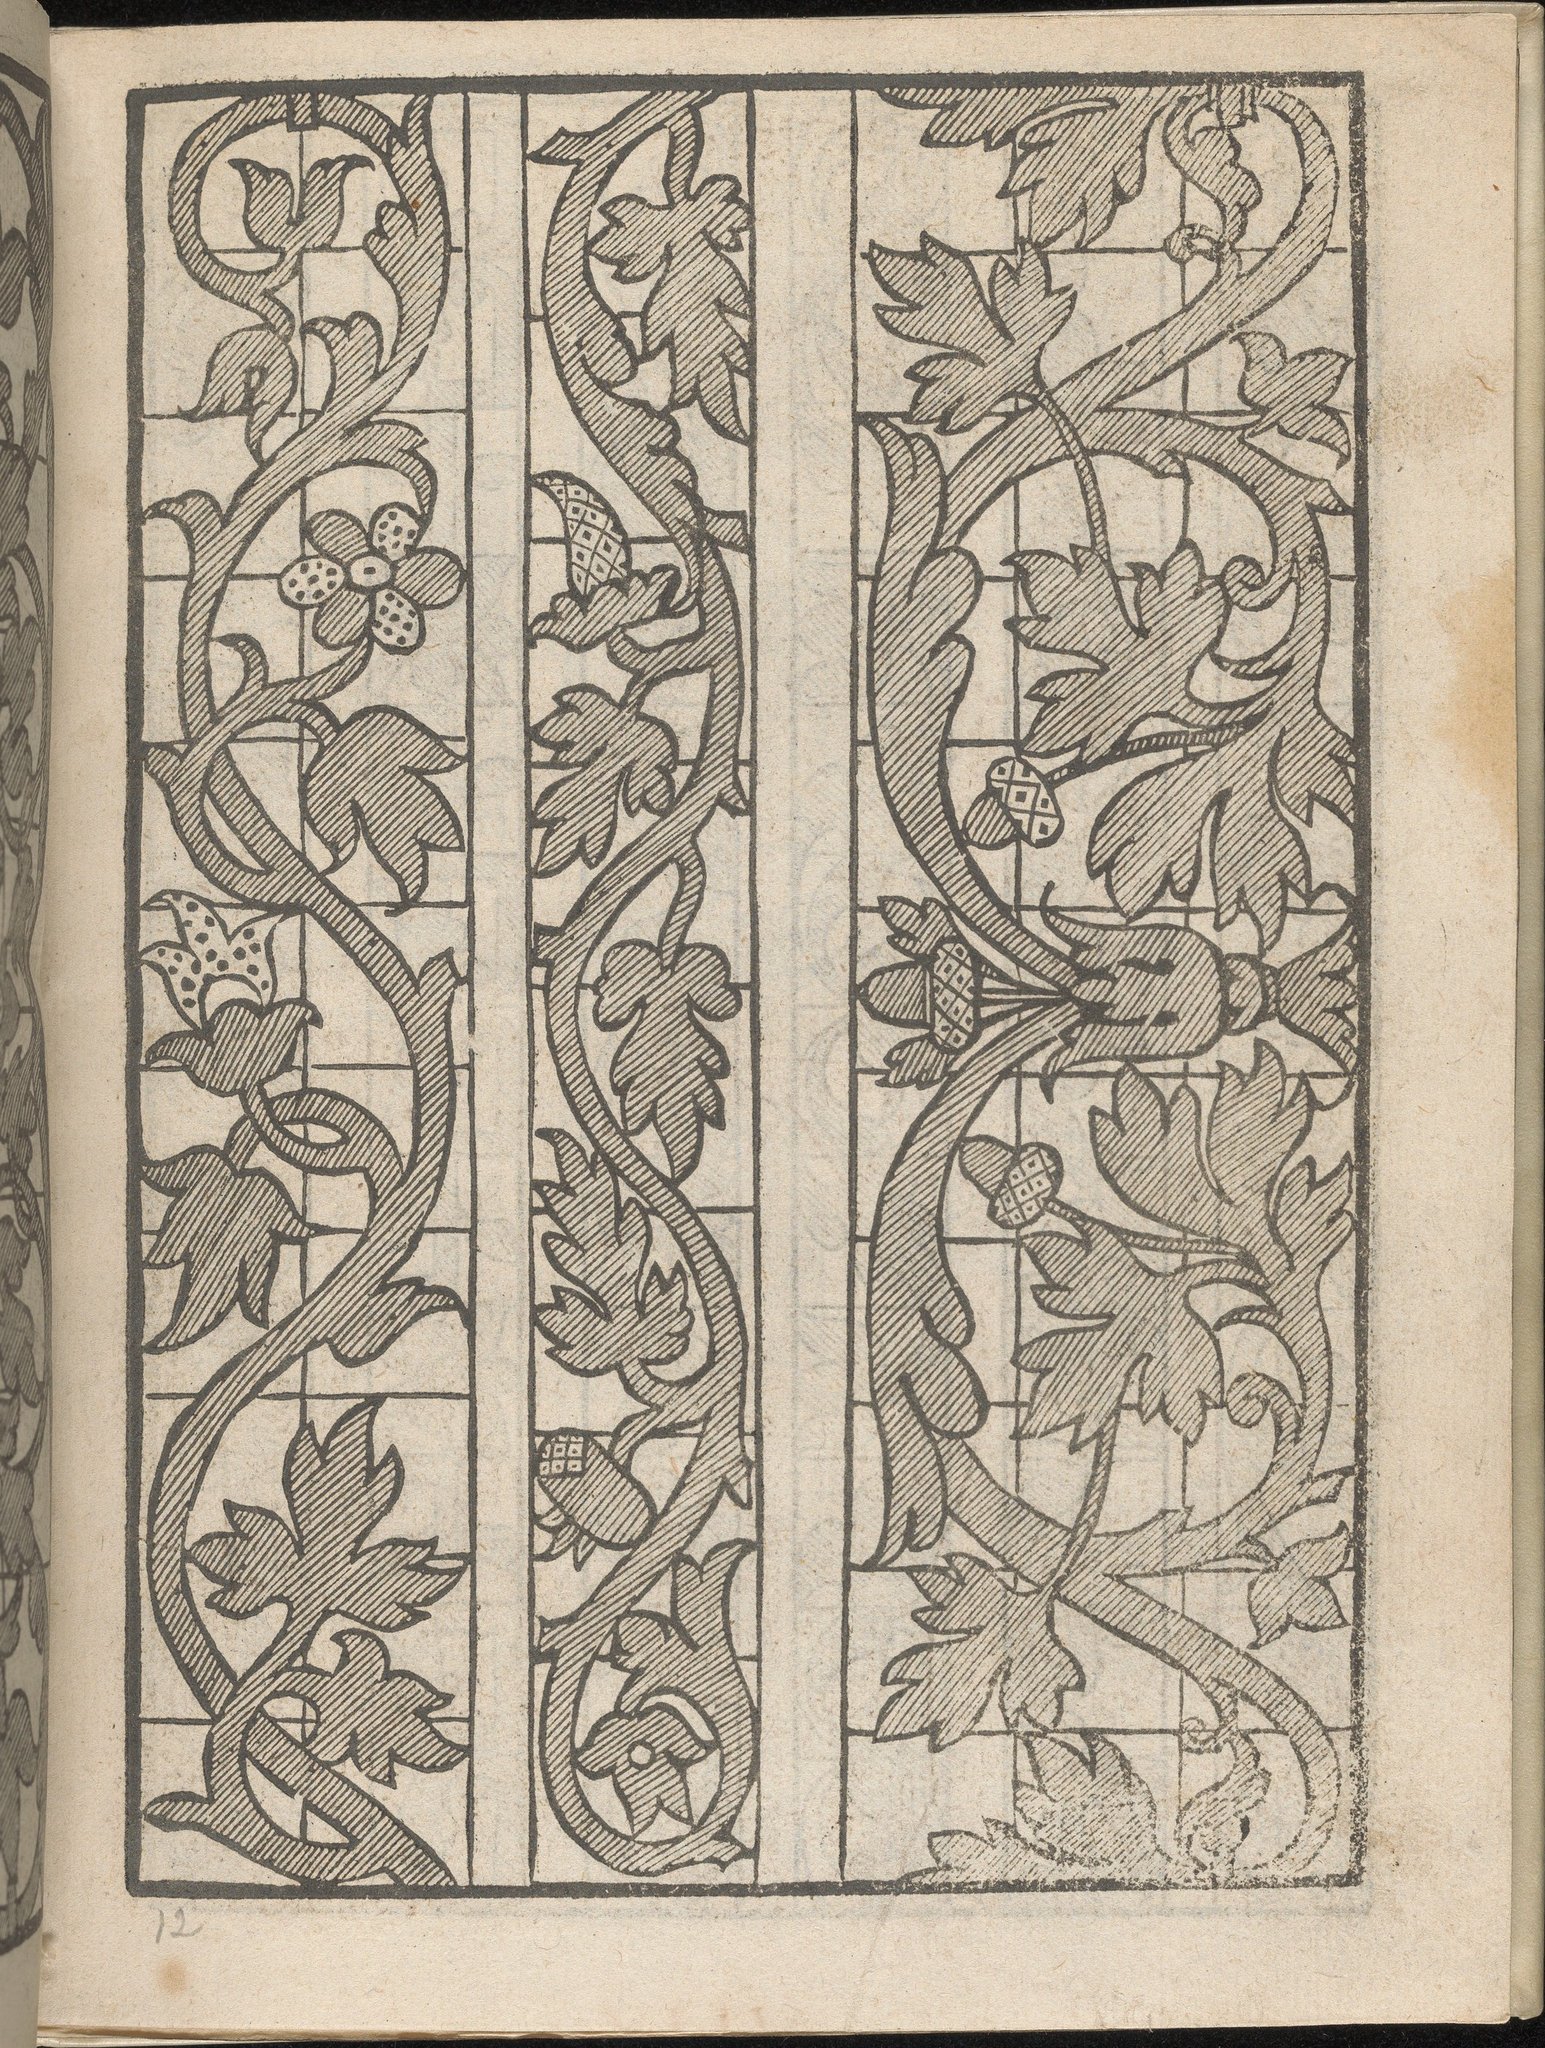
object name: book print ornament architecture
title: Lucidario di Recami, page 14 (recto)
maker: iseppo foresto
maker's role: designer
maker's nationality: italian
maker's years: 1520-1580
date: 1564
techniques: woodcut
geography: italy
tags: vines